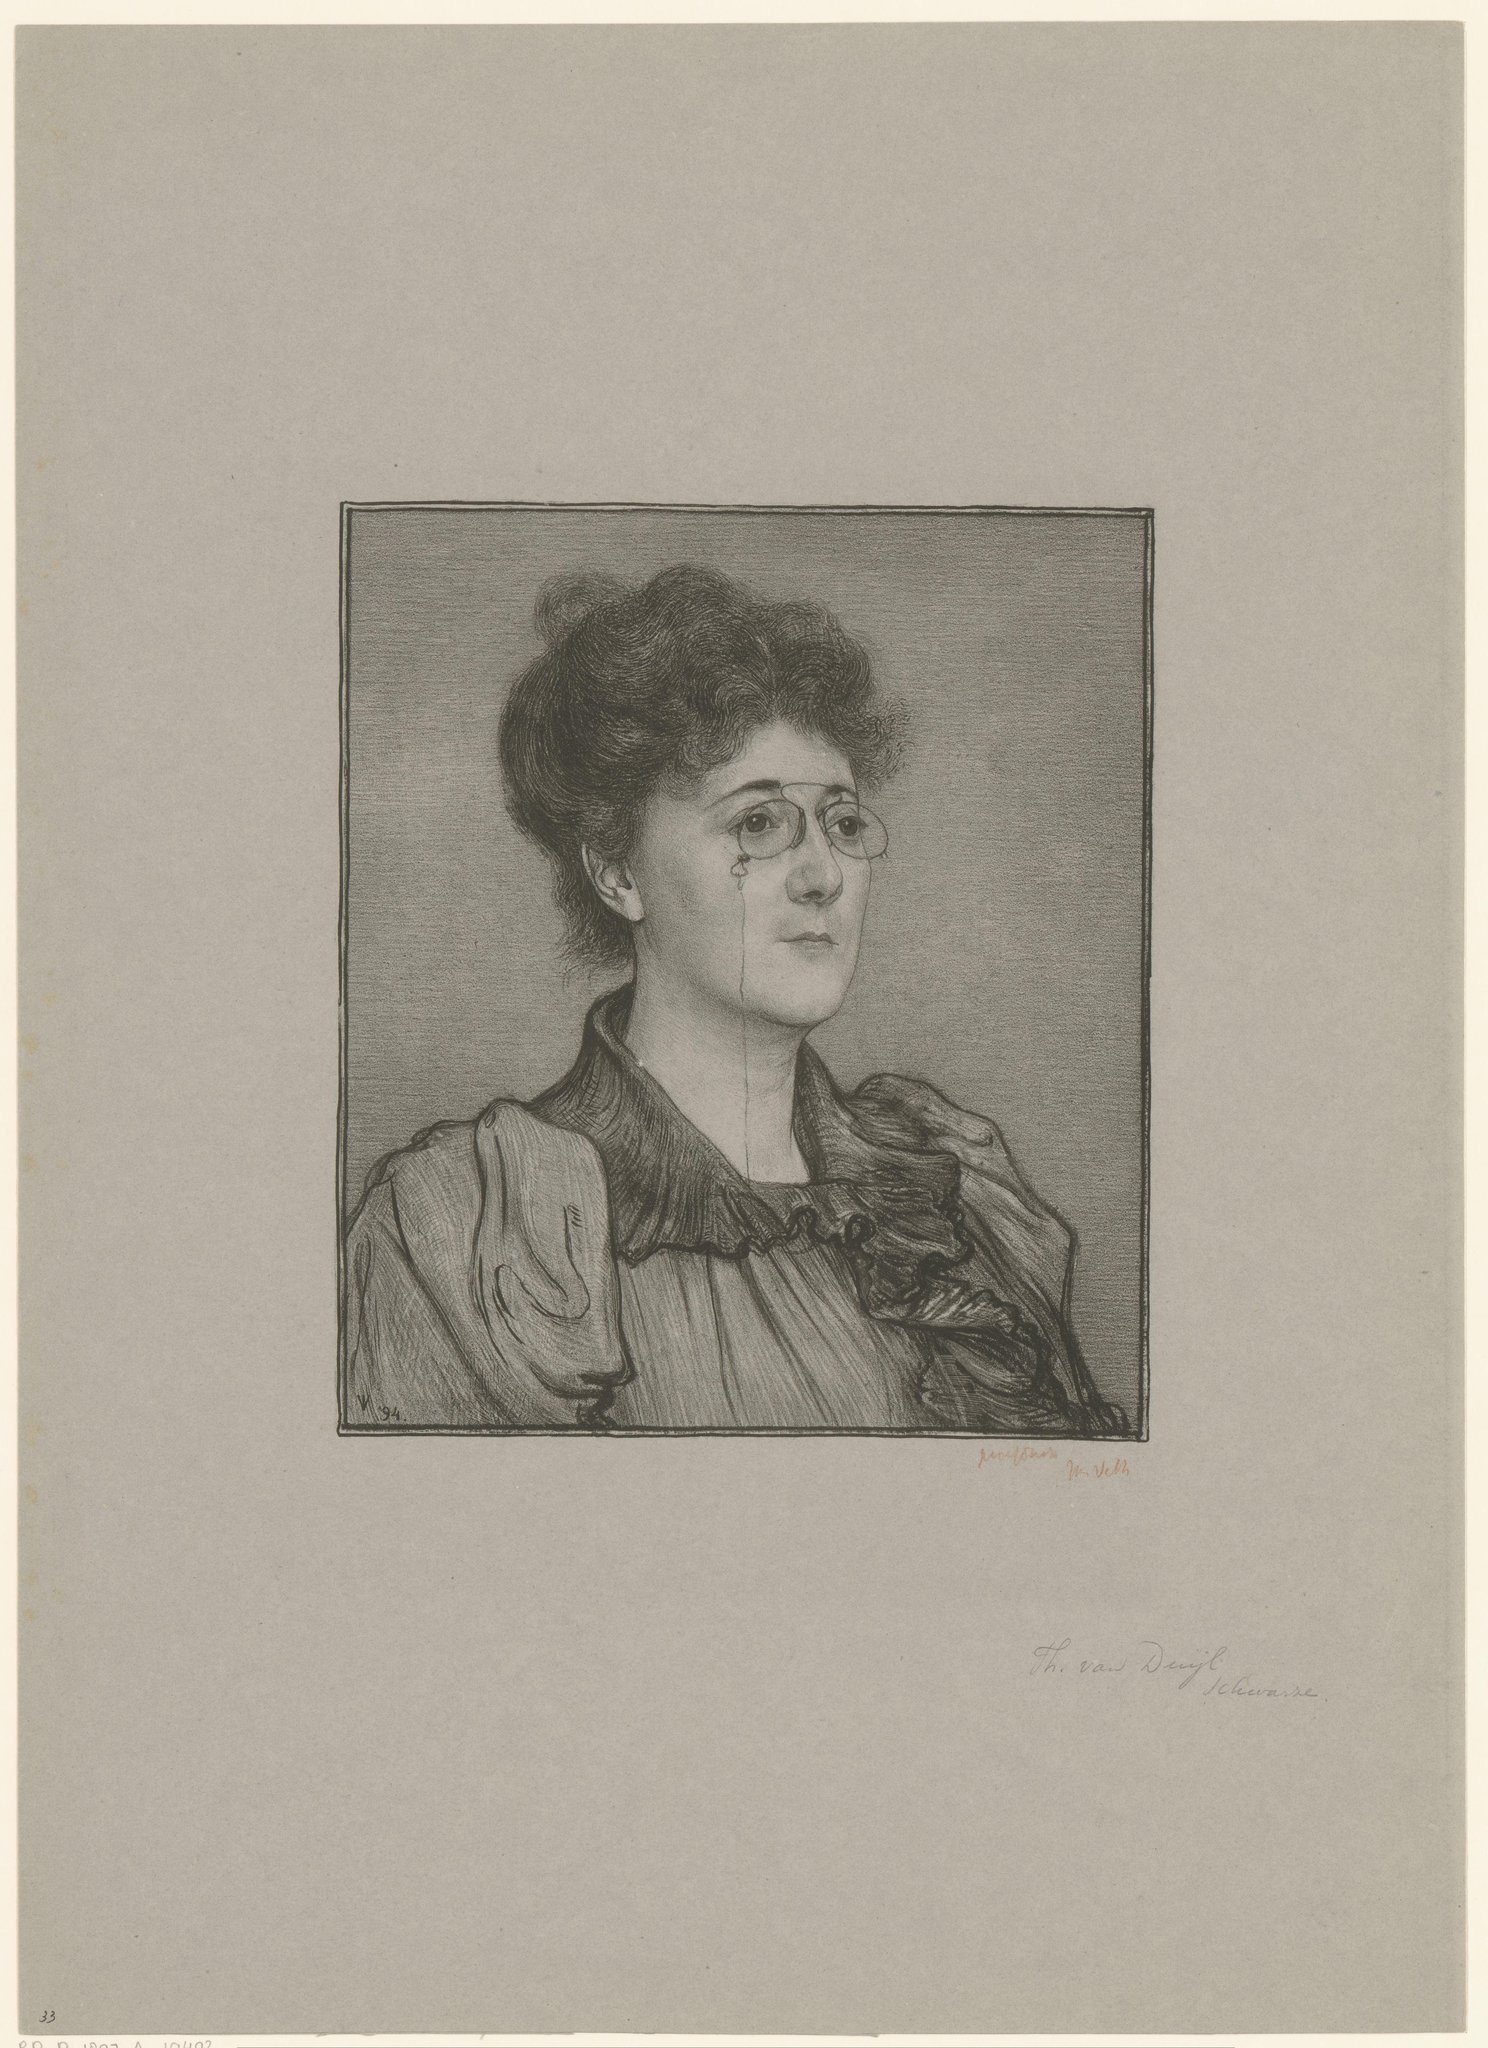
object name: print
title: Bekende tijdgenooten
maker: jan veth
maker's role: designer, draughtsman, painter, print maker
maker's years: 1864-1925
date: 1894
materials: paper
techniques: lithograph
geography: netherlands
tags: amsterdam, painter, print maker, draughtsman, thérèse schwartze, historical persons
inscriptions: collector's mark: Lugt 2228, inscription: ‘proefdruk / Jan Veth’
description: Deze prent werd uitgegeven als bijvoegsel van De Amsterdammer op 4 november 1894.